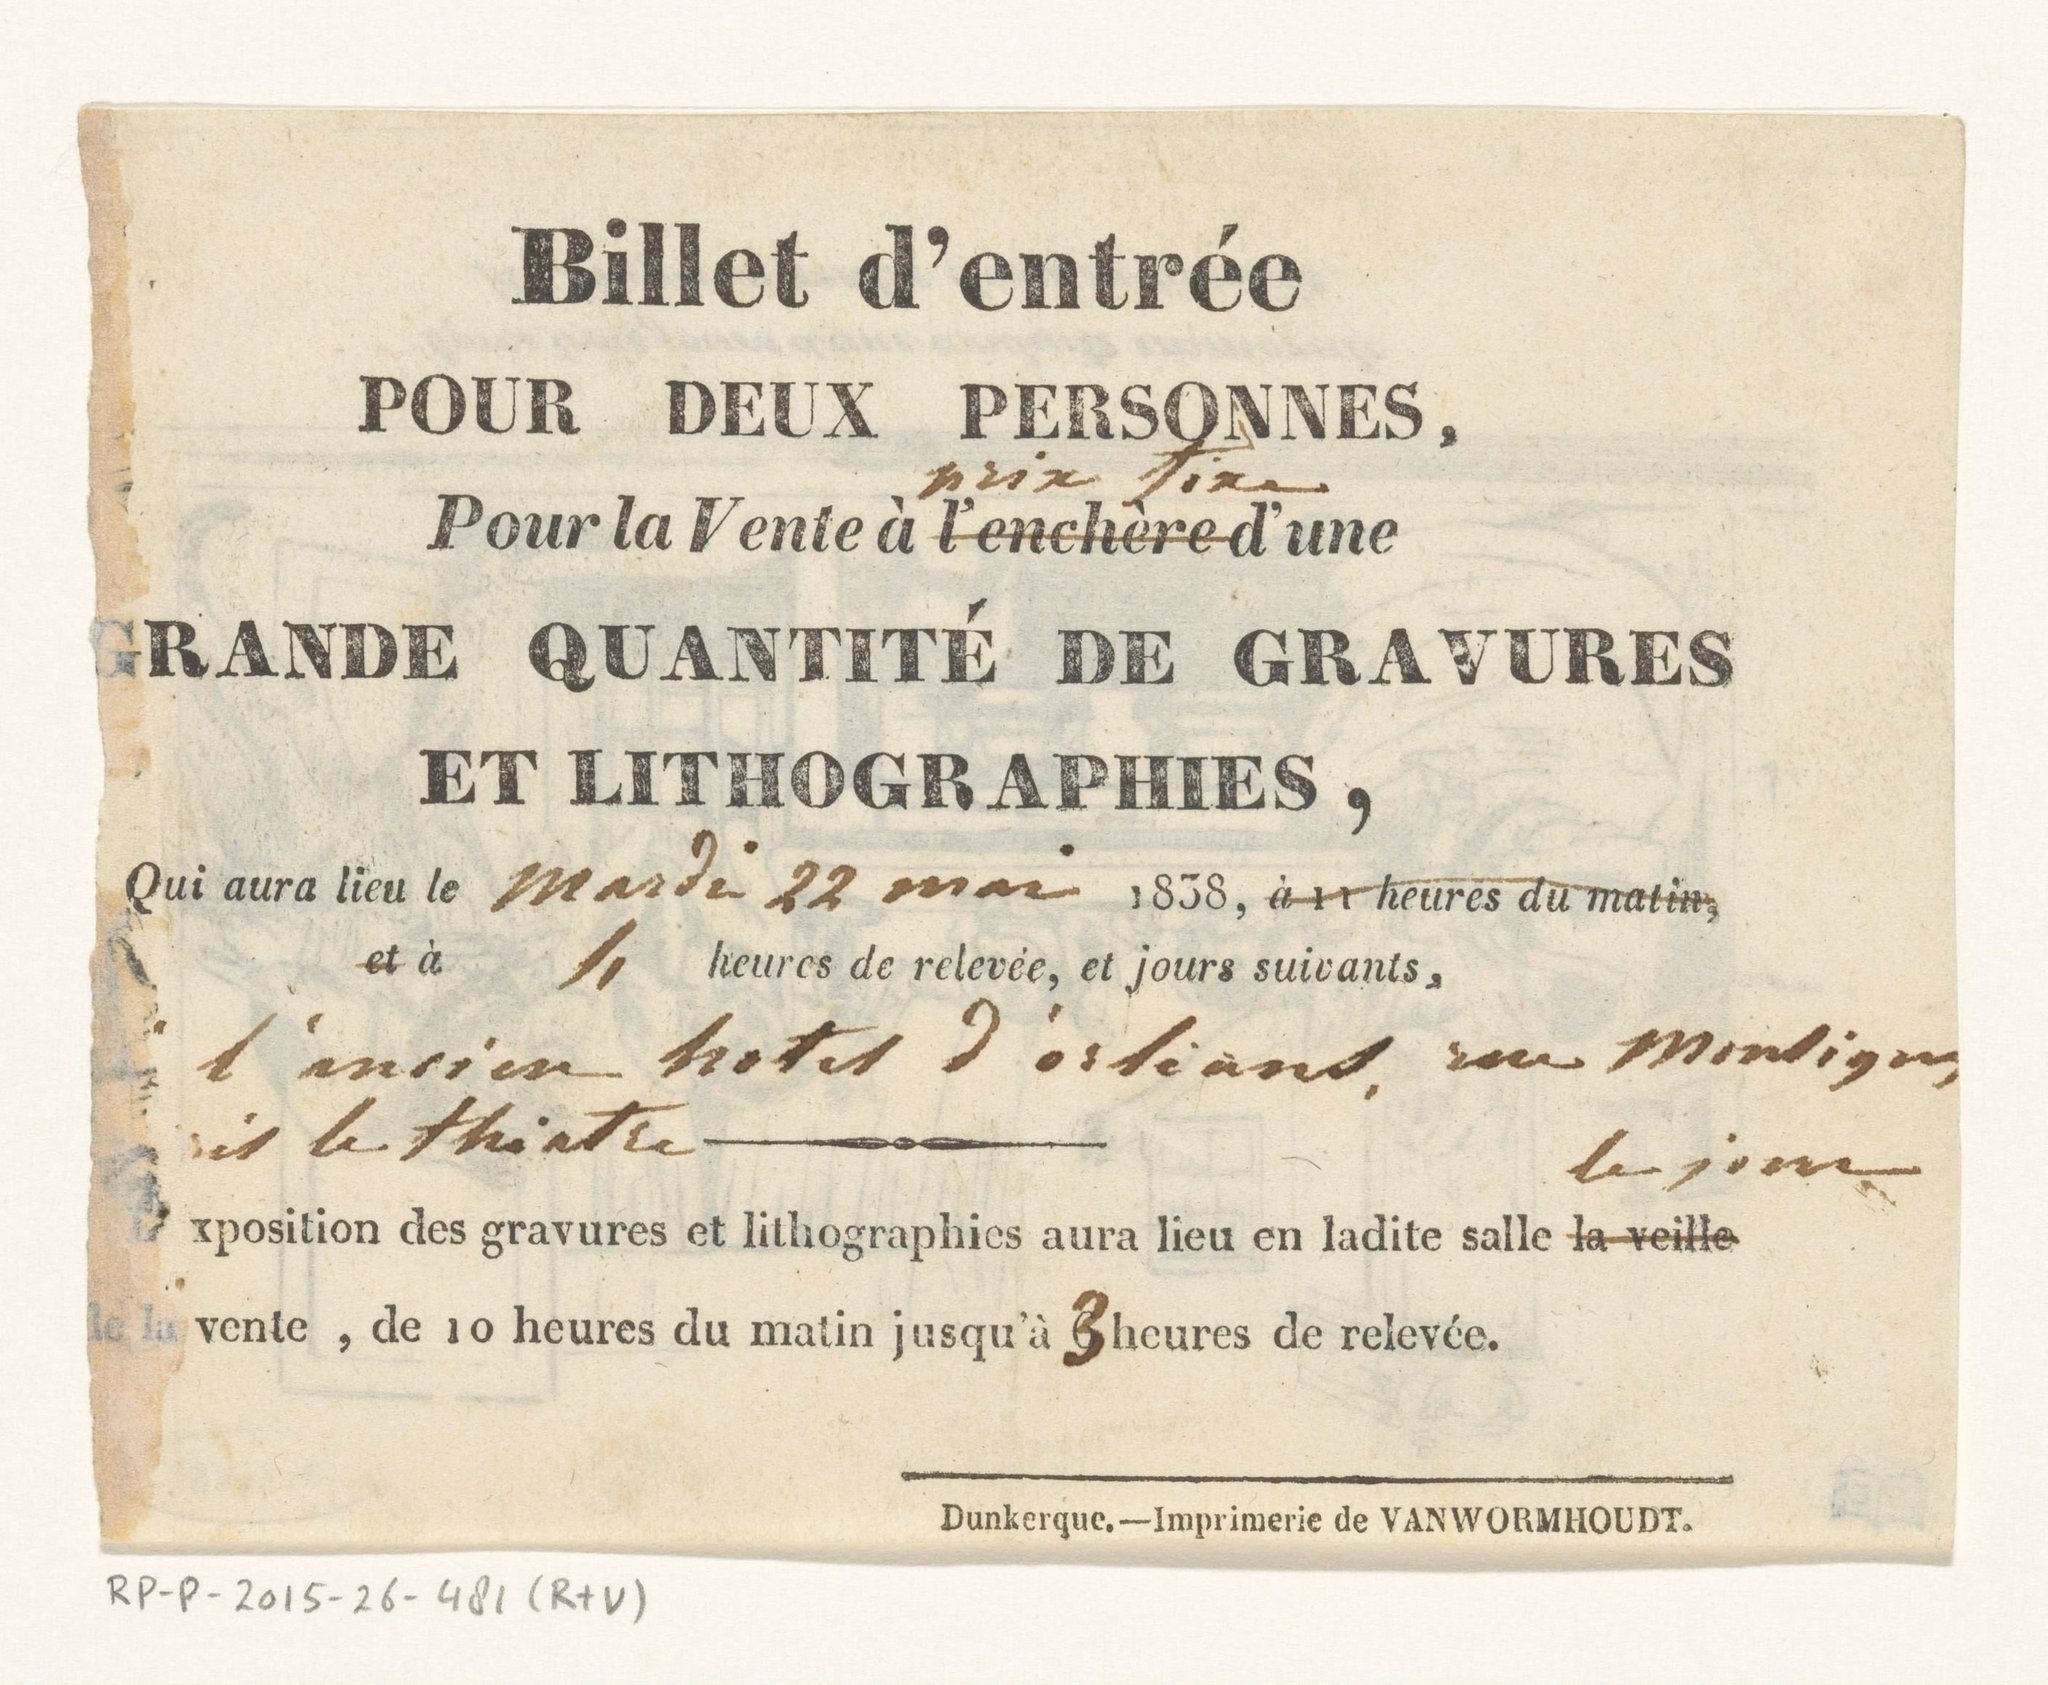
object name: admission ticket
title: Entreebewijs voor een prentenveiling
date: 1805-1838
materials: ink, paper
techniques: lithograph, pen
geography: dunkirk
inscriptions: date